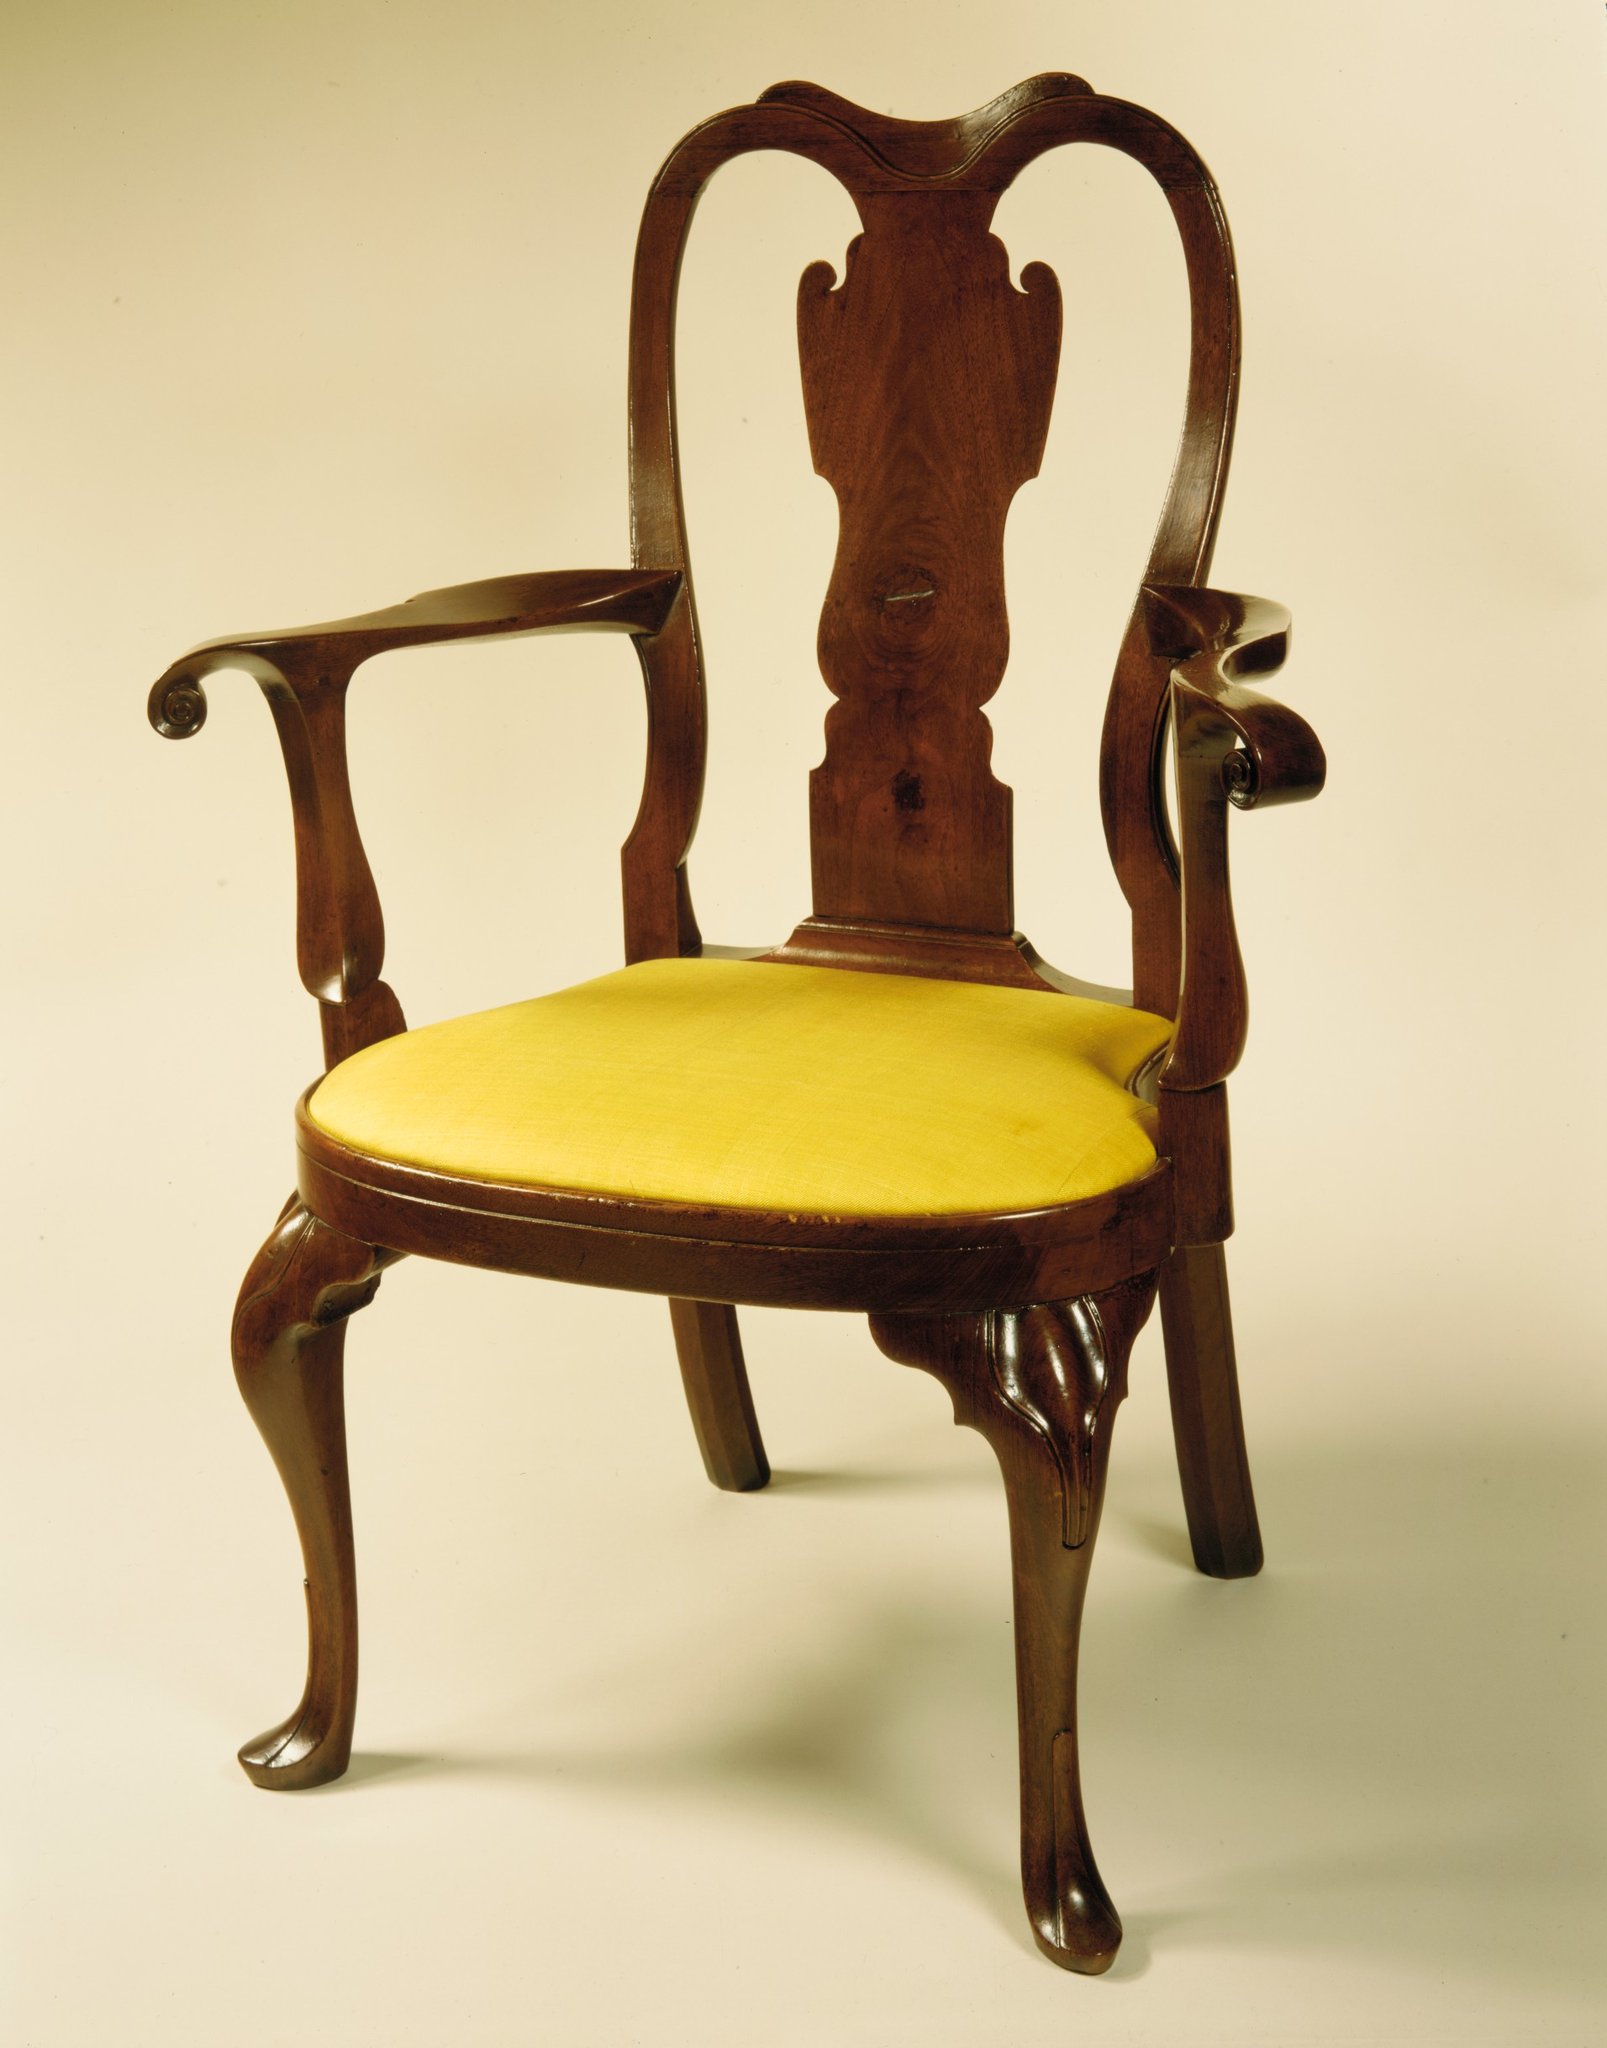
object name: armchair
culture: american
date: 1740-1760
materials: wood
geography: united states